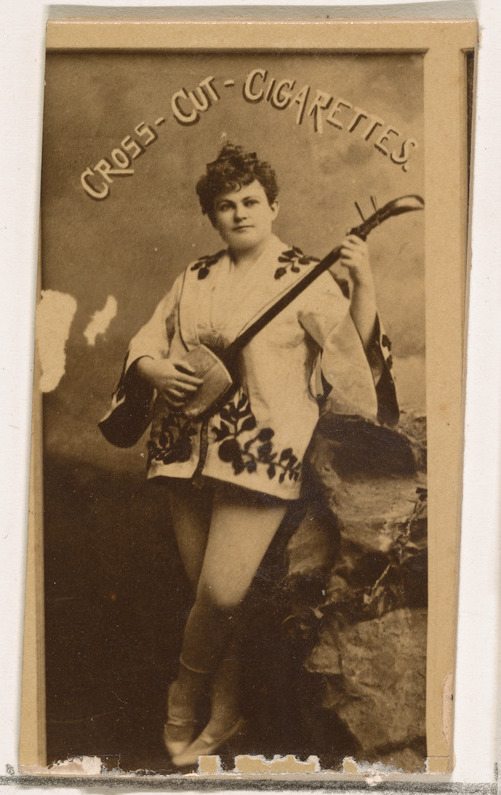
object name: print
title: Actress playing stringed instrument, from the Actors and Actresses series (N145-1) issued by Duke Sons & Co. to promote Cross Cut Cigarettes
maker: w. duke, sons & co.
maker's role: publisher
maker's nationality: american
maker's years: 1870-1920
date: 1880-1889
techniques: albumen silver print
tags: musical instruments,portraits,women,actresses